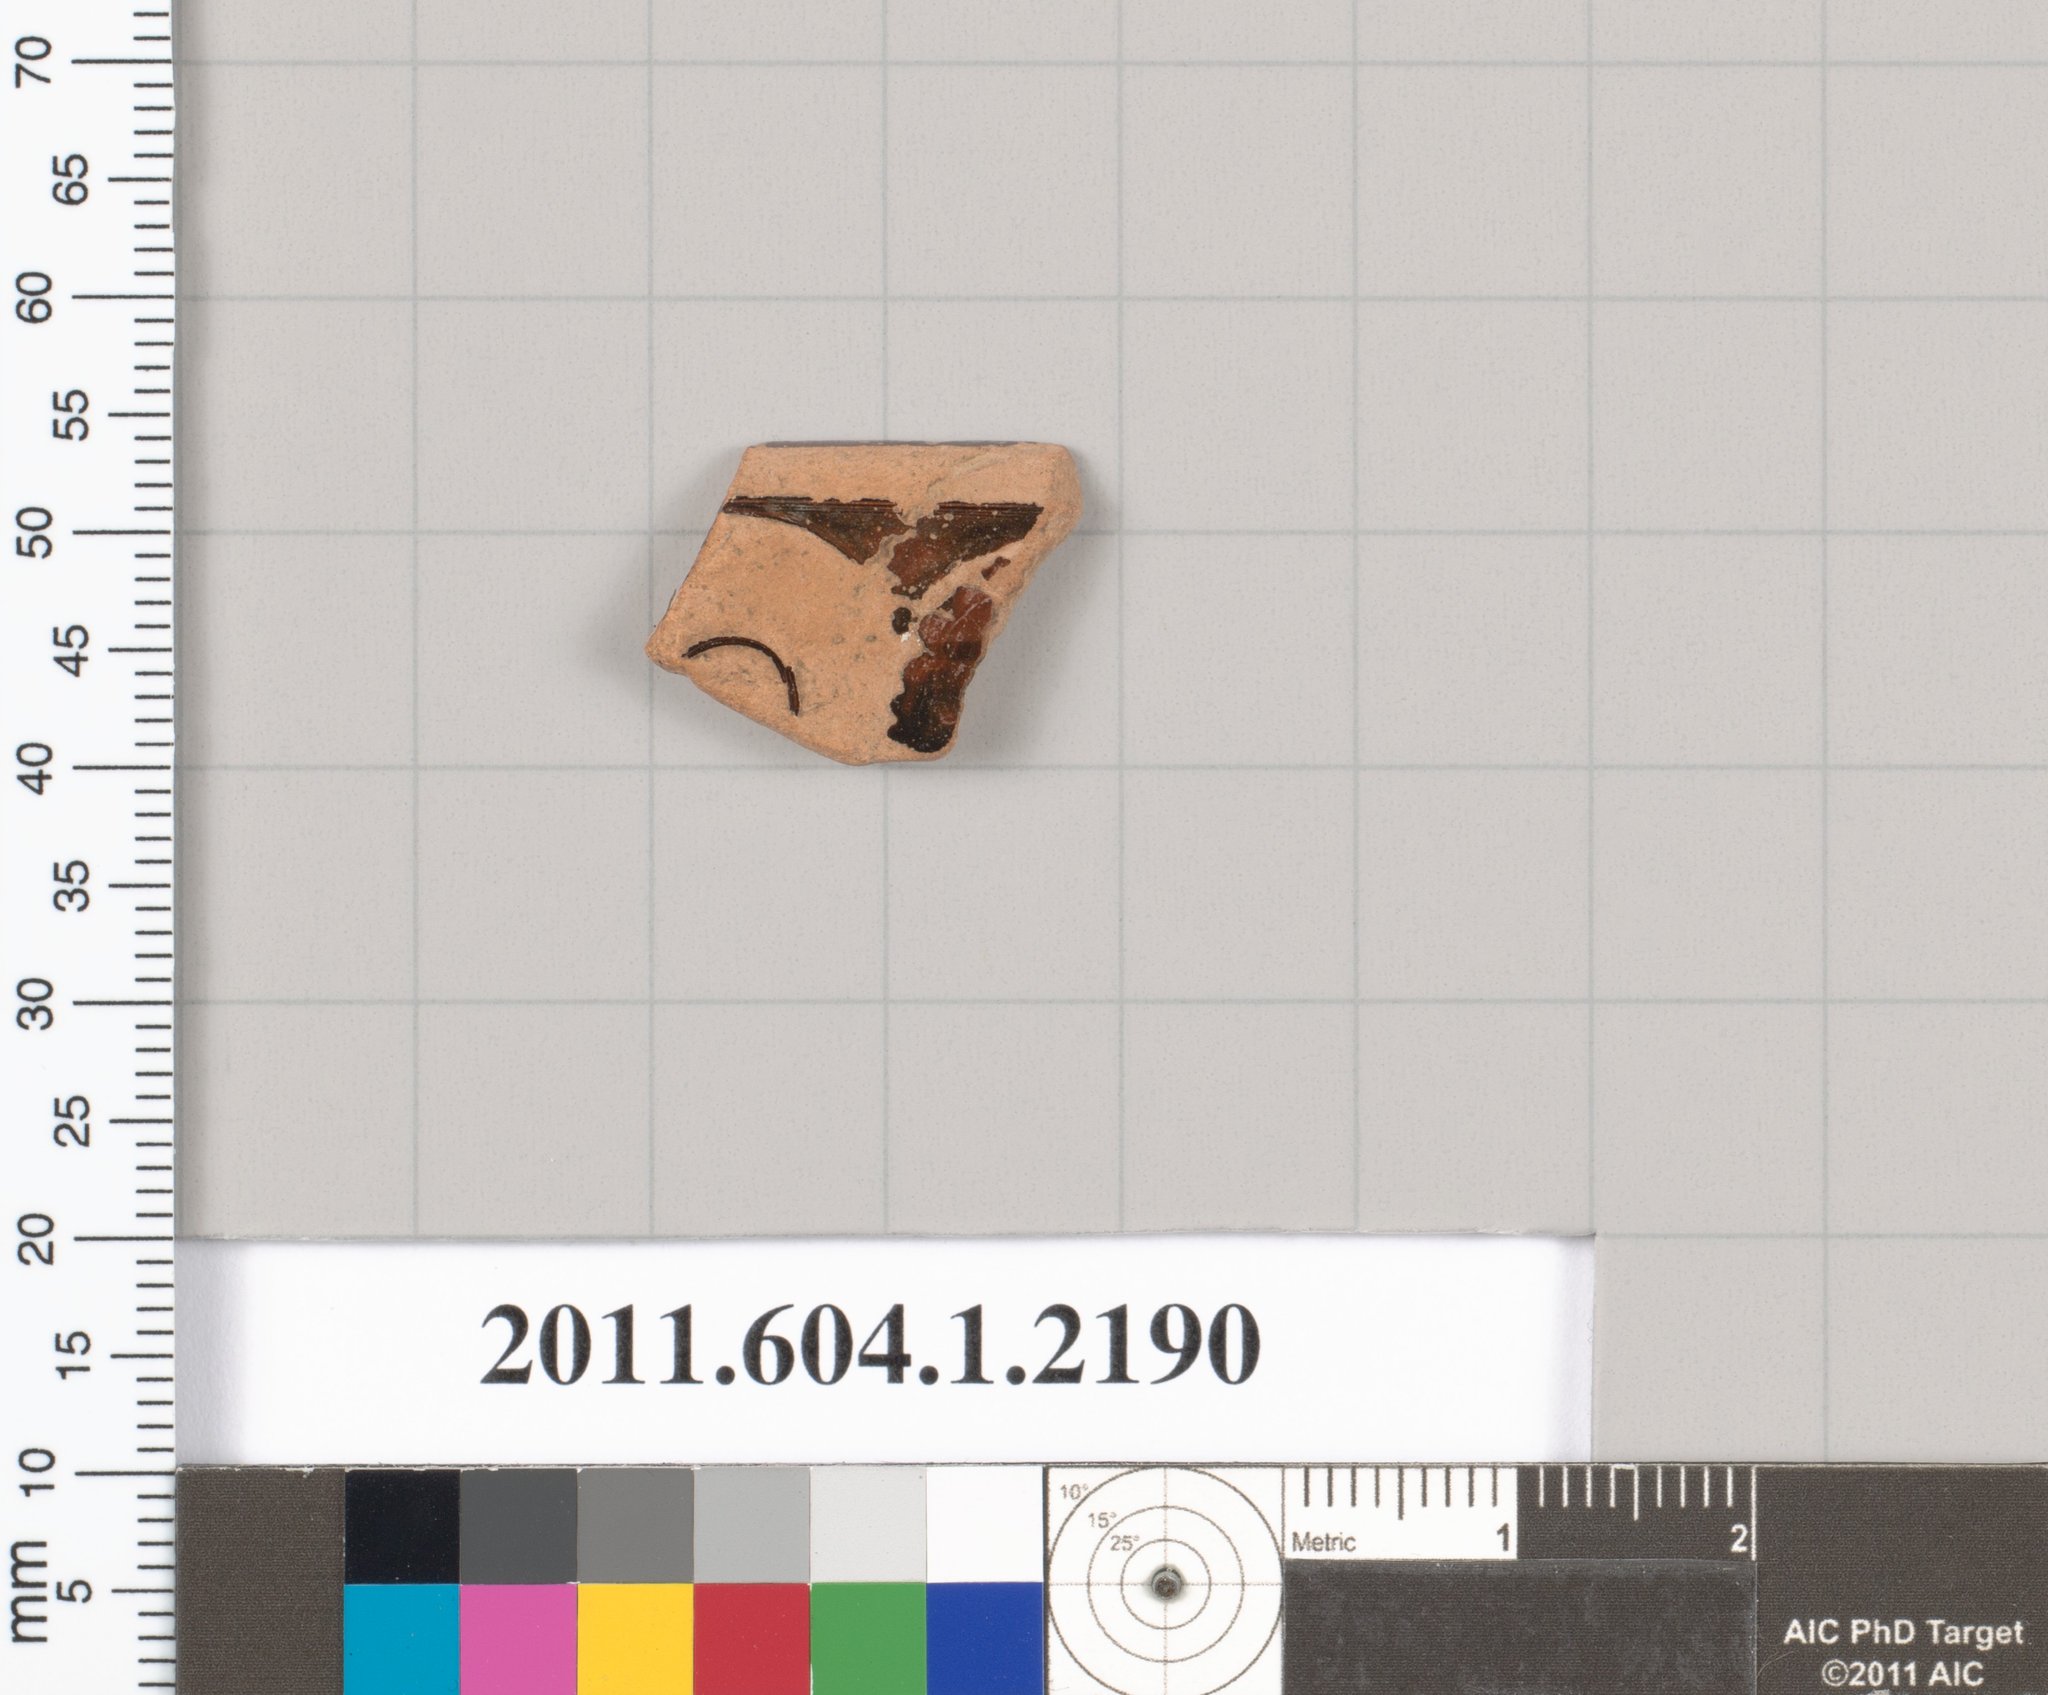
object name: kylix fragment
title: Terracotta rim fragment of a kylix (drinking cup)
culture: greek, attic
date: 475-451 BCE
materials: terracotta